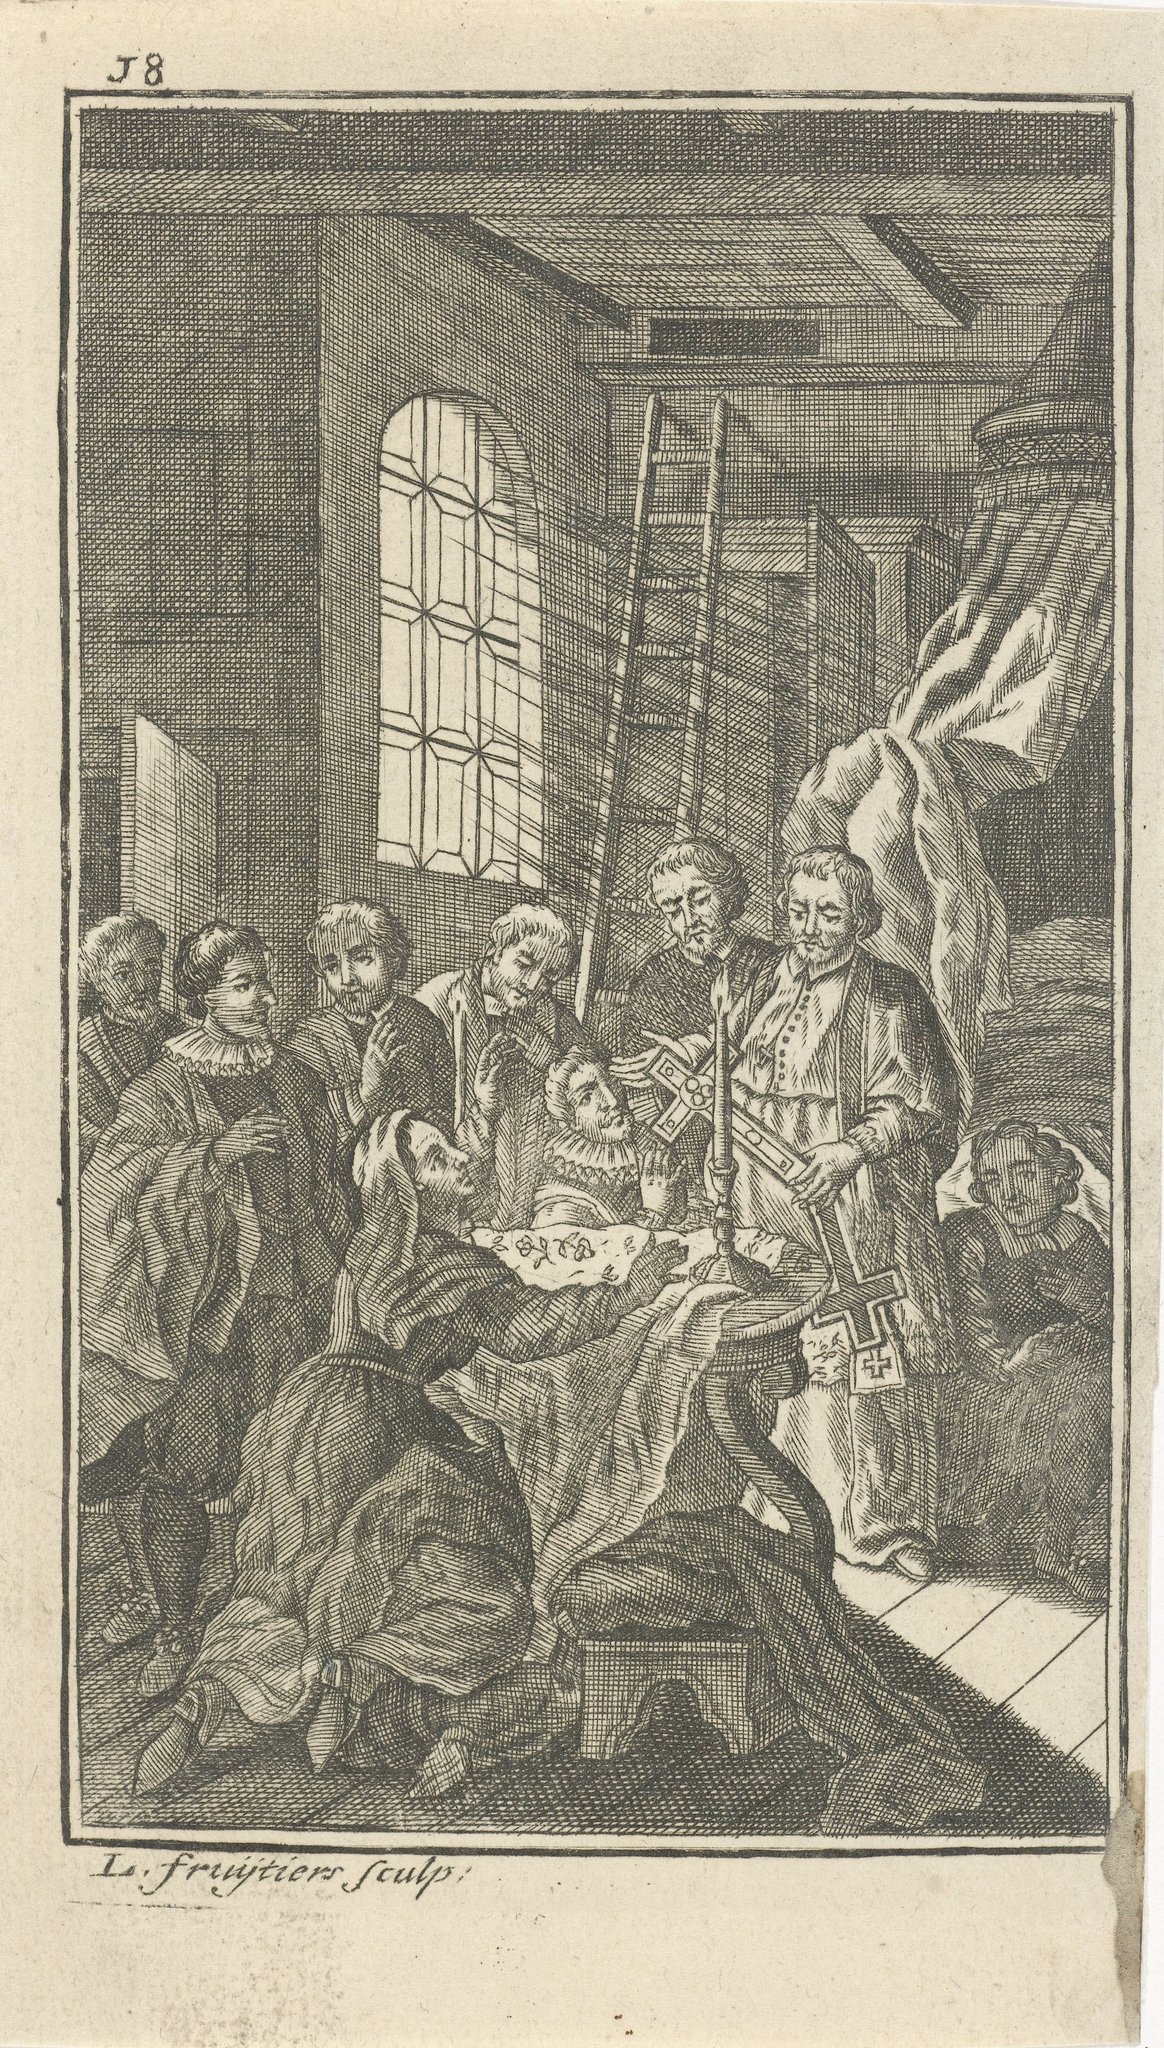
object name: print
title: Geschiedenis van het Heilig Mirakel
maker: lodewijk joseph fruytiers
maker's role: print maker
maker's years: 1713-1782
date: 1723-1783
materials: paper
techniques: engraving, etching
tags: adoration of the host, e.g. perpetual adoration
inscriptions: inscription: ‘Mirakels’, collector's mark: Lugt 2228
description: Aanbidding van het Heilige Sacrament tijdens een kleine religieuze bijeenkomst. Een man en vrouw zitten geknield met de handen ineengevouwen in aanbidding voor het Heilige Kruis dat door een geestelijke wordt opgehouden.